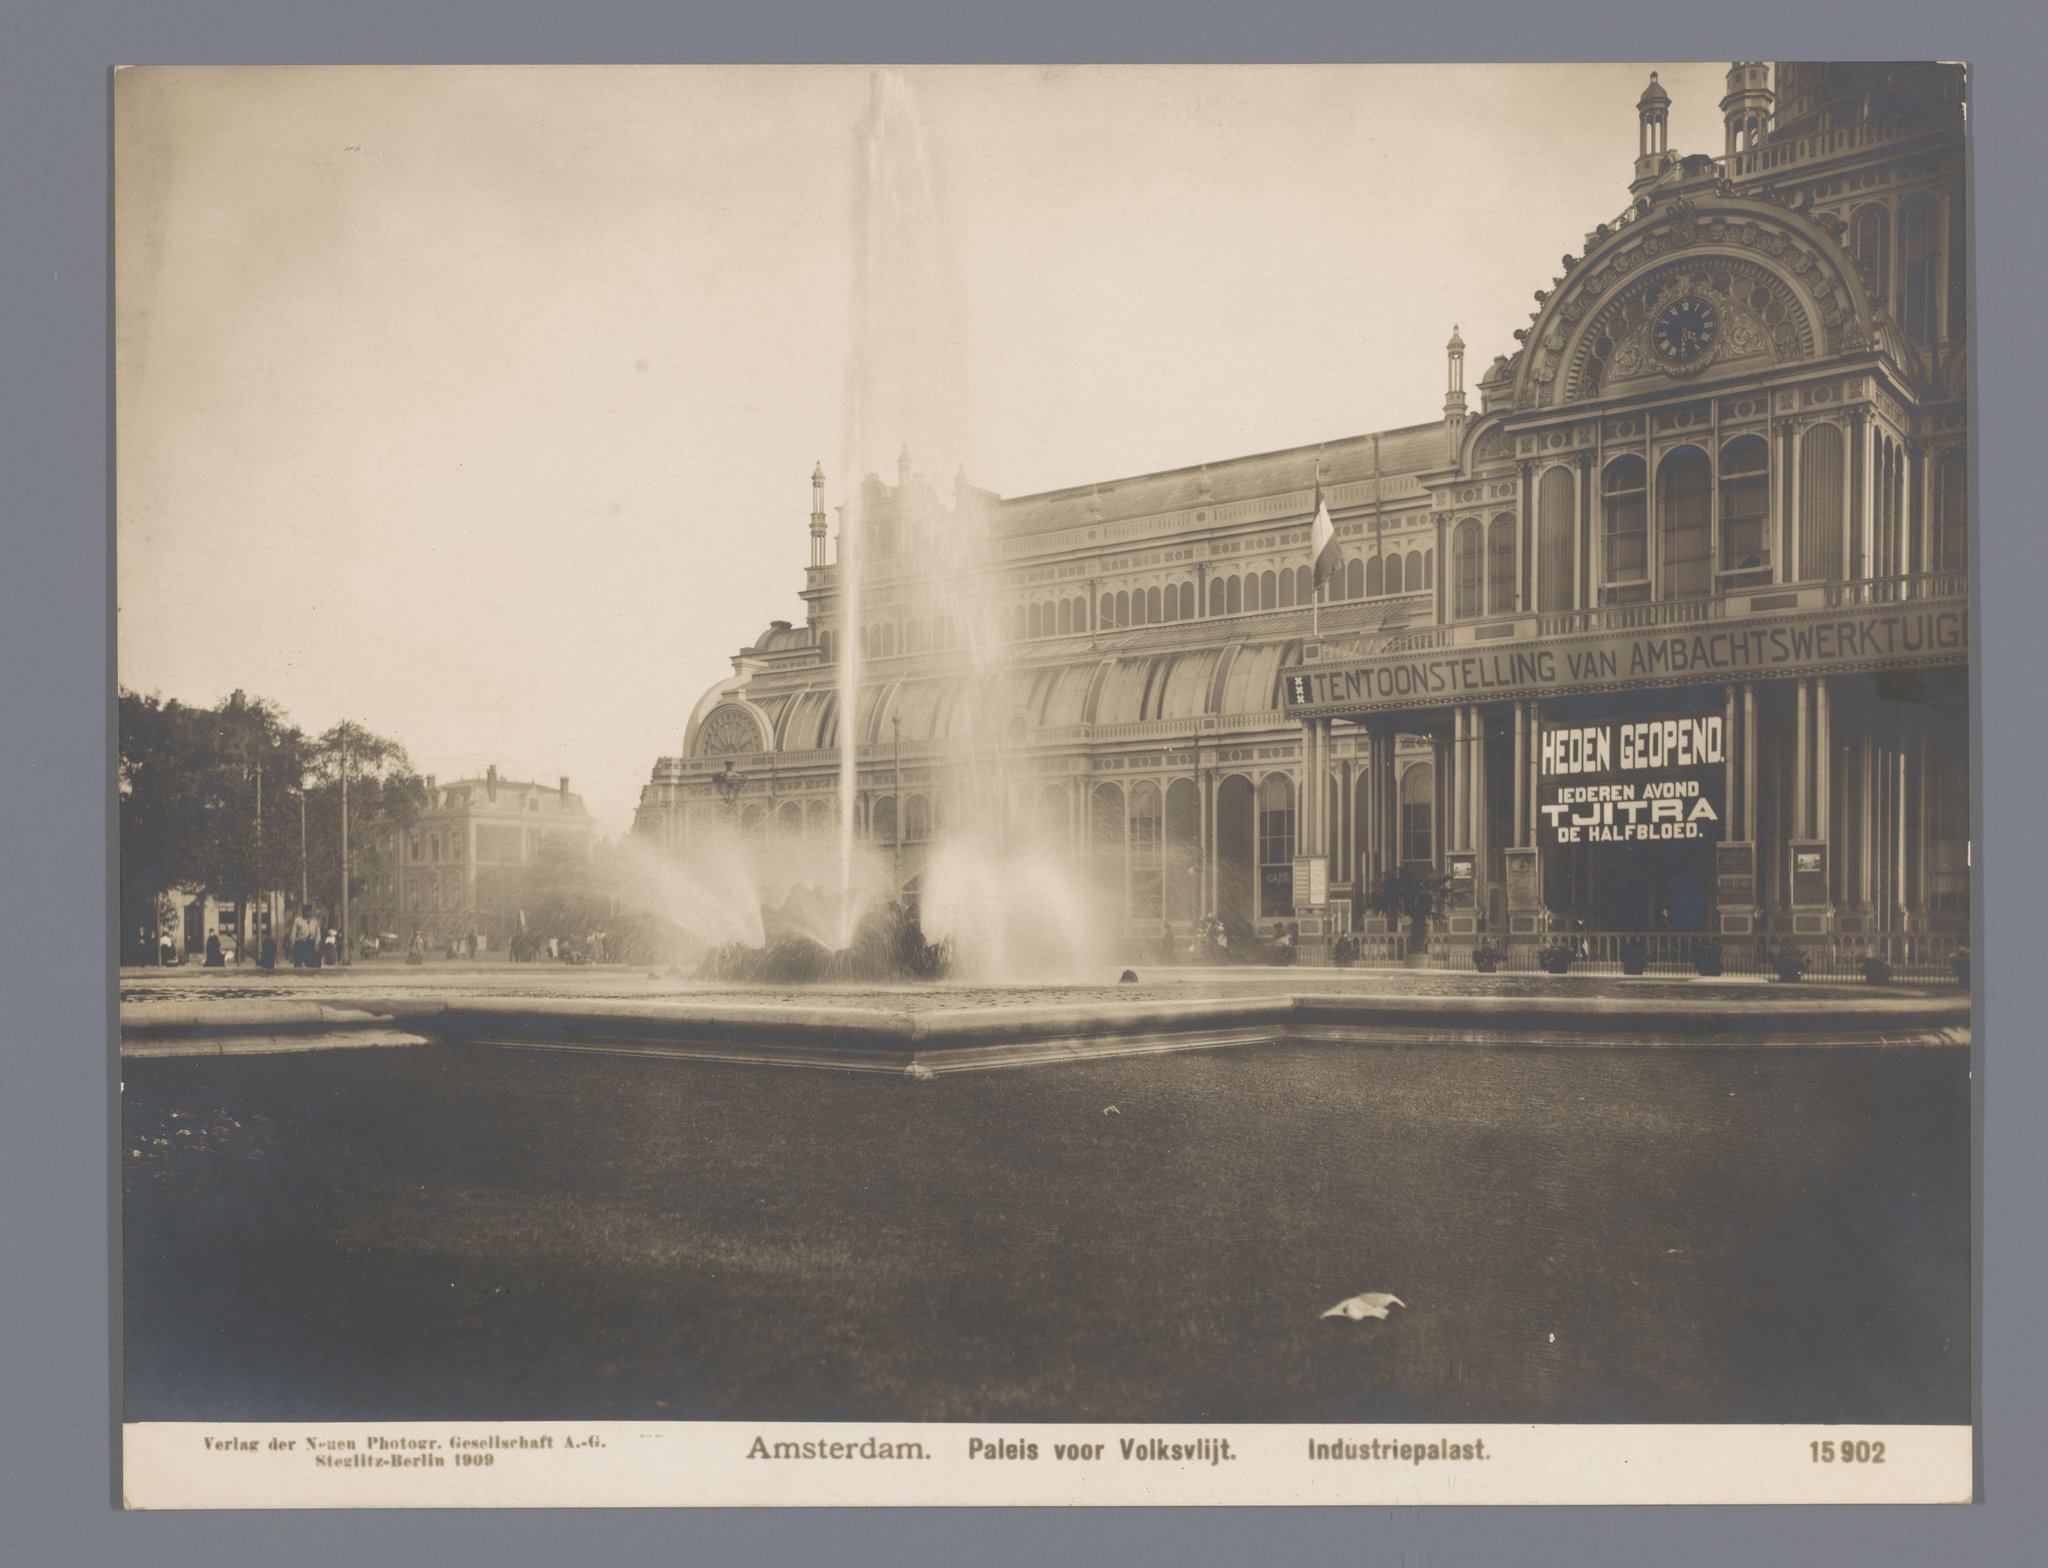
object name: photograph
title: Amsterdam. Paleis voor Volksvlijt. Industriepalast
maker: Anonymous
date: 1909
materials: paper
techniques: gelatin silver print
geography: amsterdam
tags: ornamental fountain, edifice, e.g.: public building, department store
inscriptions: inscription: ‘Verlag der Neuen Photogr. Gesellschaft A.-G./ Steglitz-Berlin 1909/ Amsterdam. Paleis voor Volksvlijt Industriepalast. 15902’